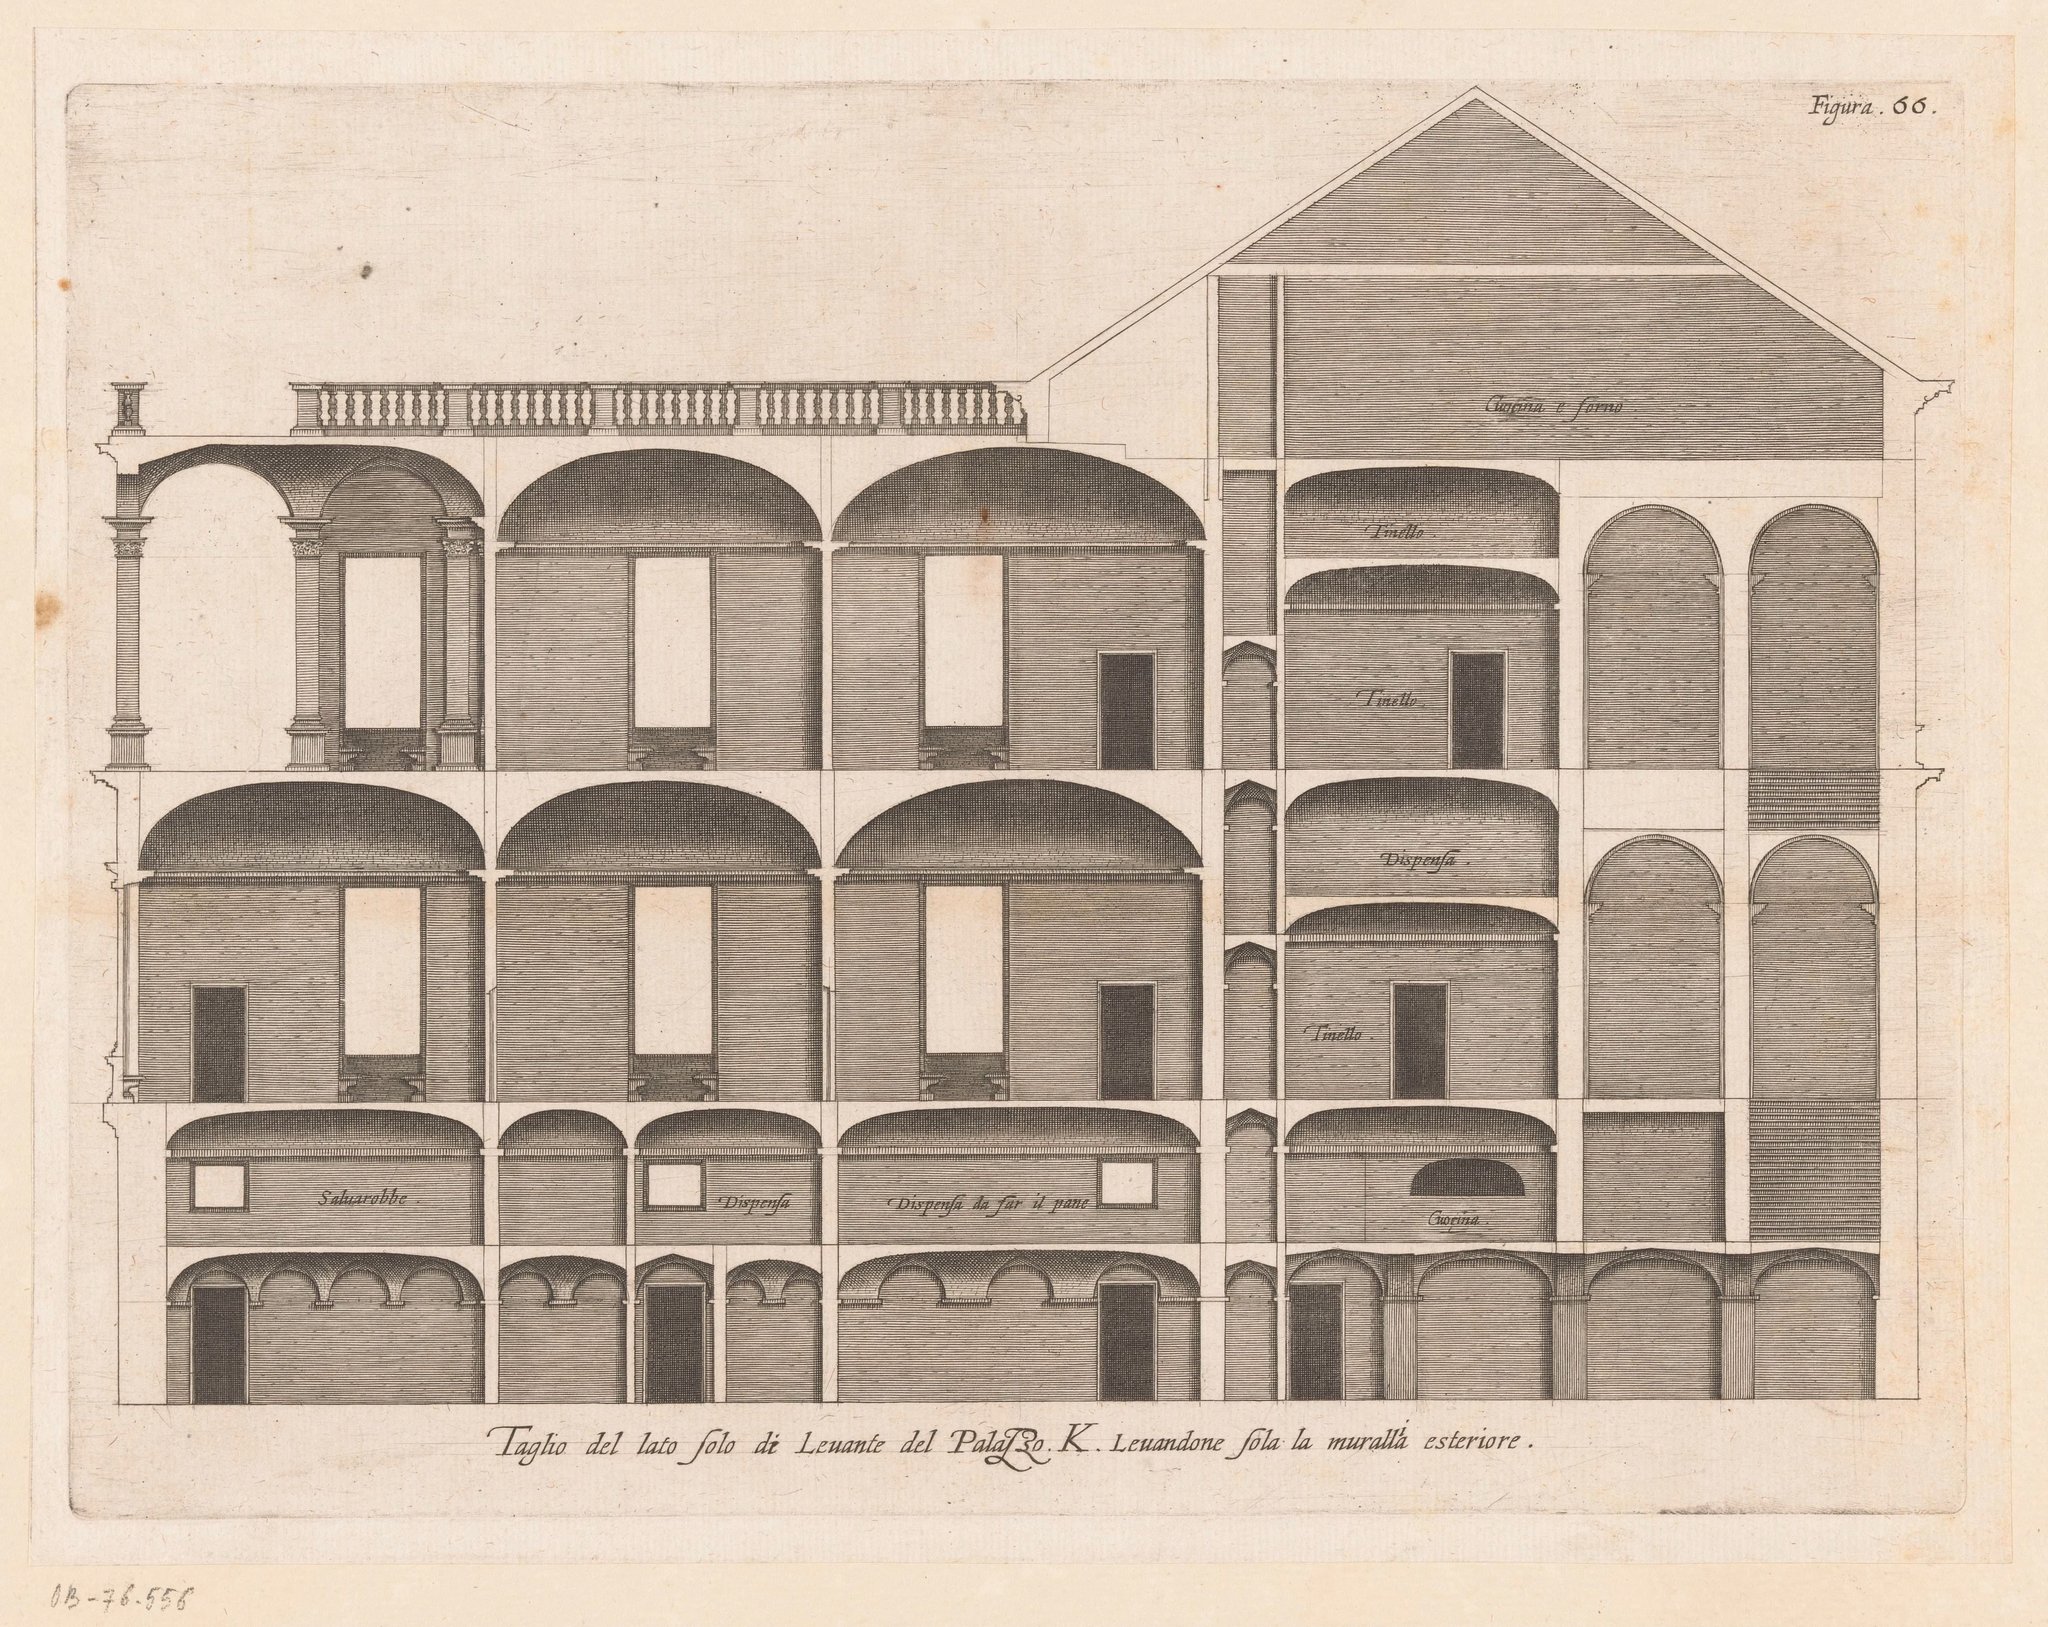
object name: ornament print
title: Taglio del lato solo di levante del Palazzo. K. levandone sola la murallia esteriore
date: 1622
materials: paper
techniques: engraving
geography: antwerp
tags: hôtel, i.e. small palace in city - aa - civic architecture: inside, section ~ architectural design or model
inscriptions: collector's mark: Lugt 240